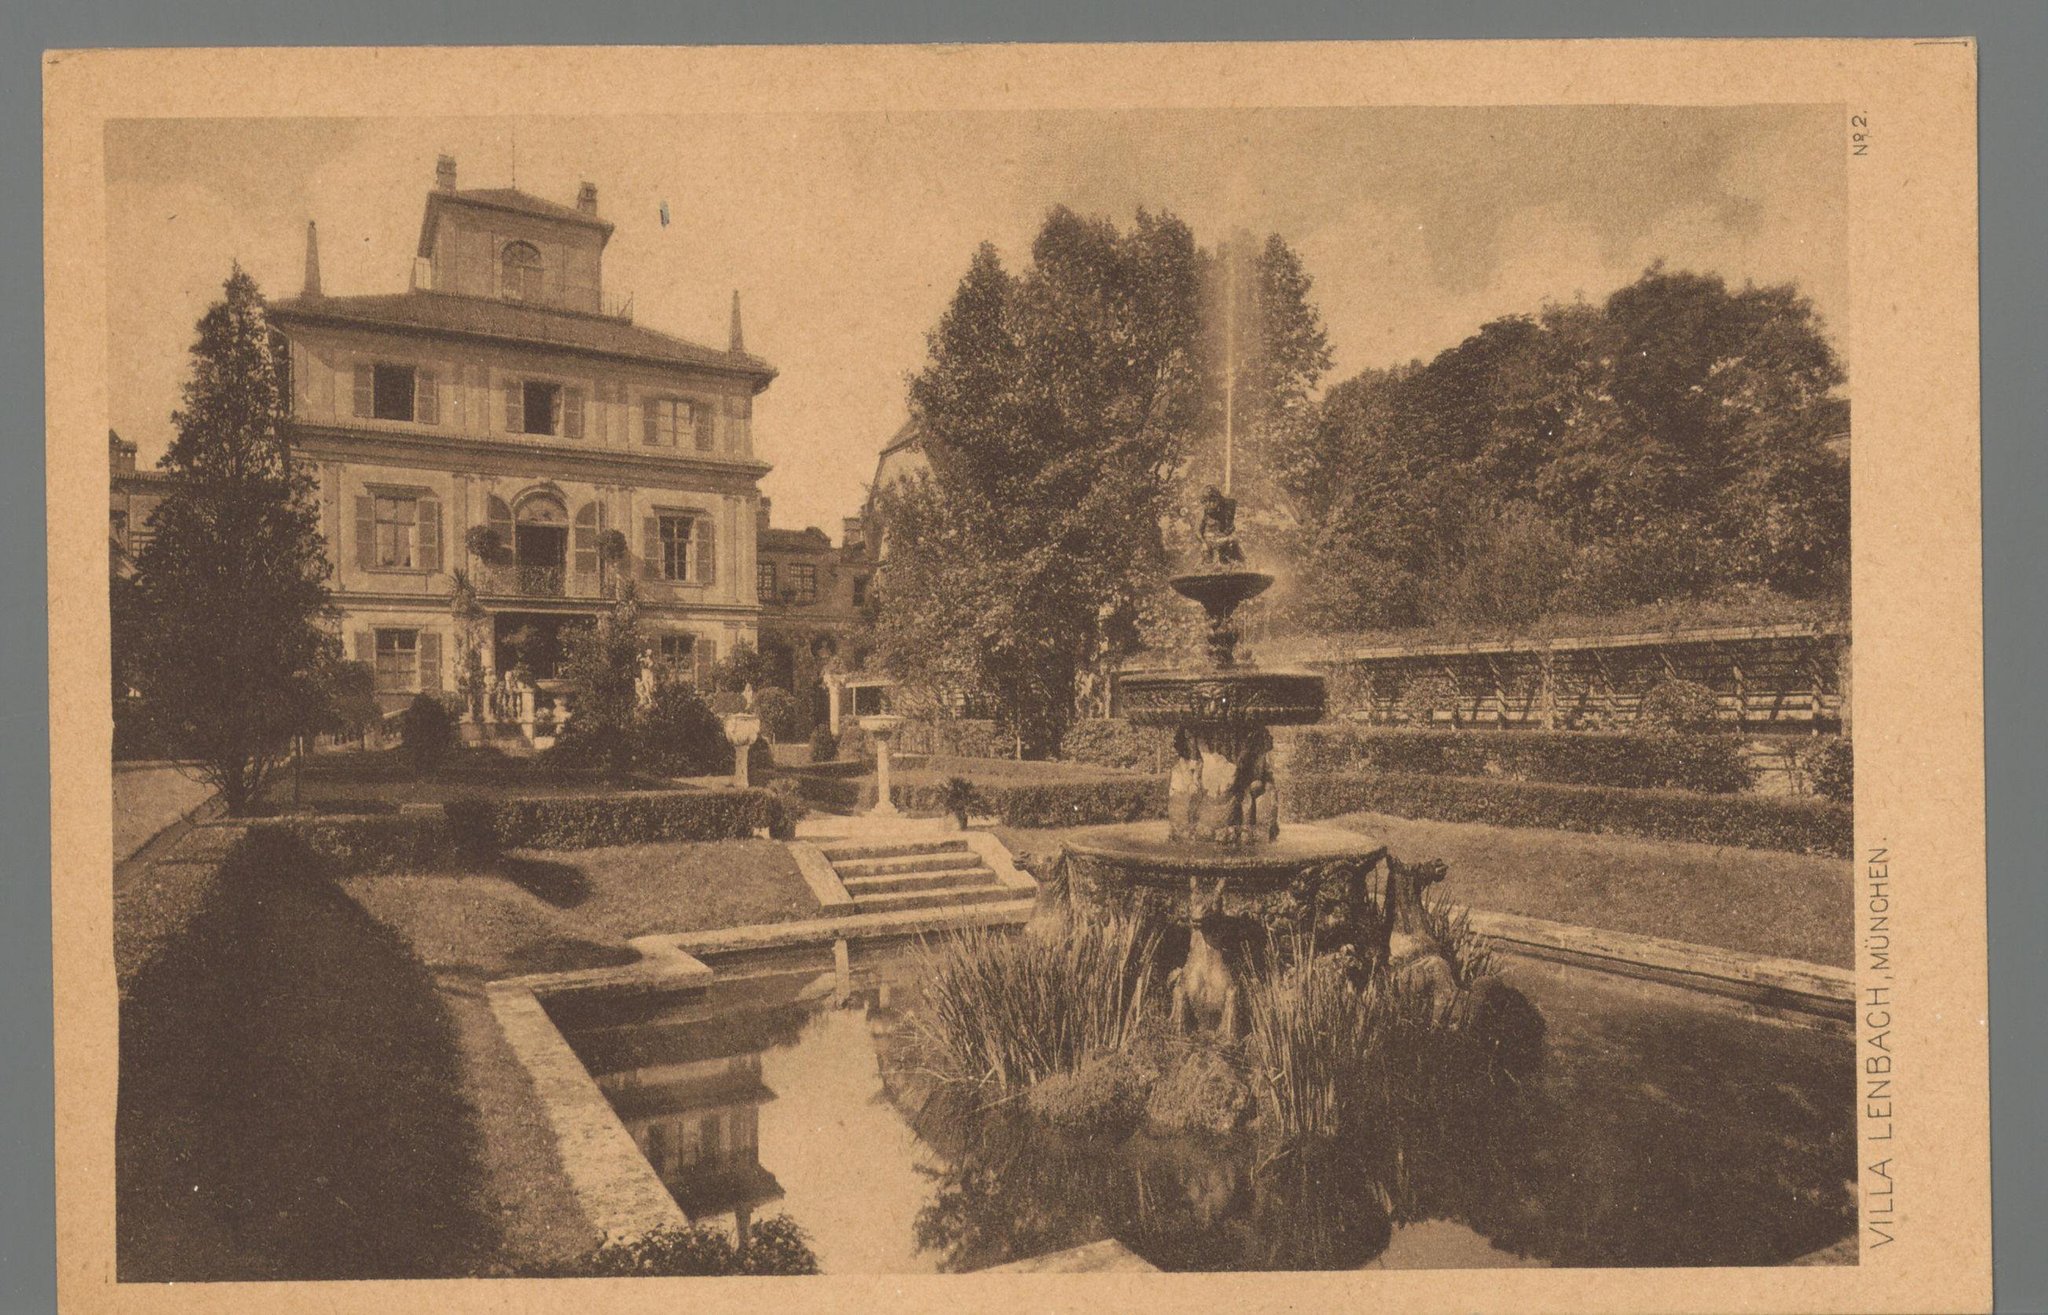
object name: photomechanical print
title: Villa Lenbach, München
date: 1905-1930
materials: cardboard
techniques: photoaquatint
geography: munich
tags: monument, statue, villa